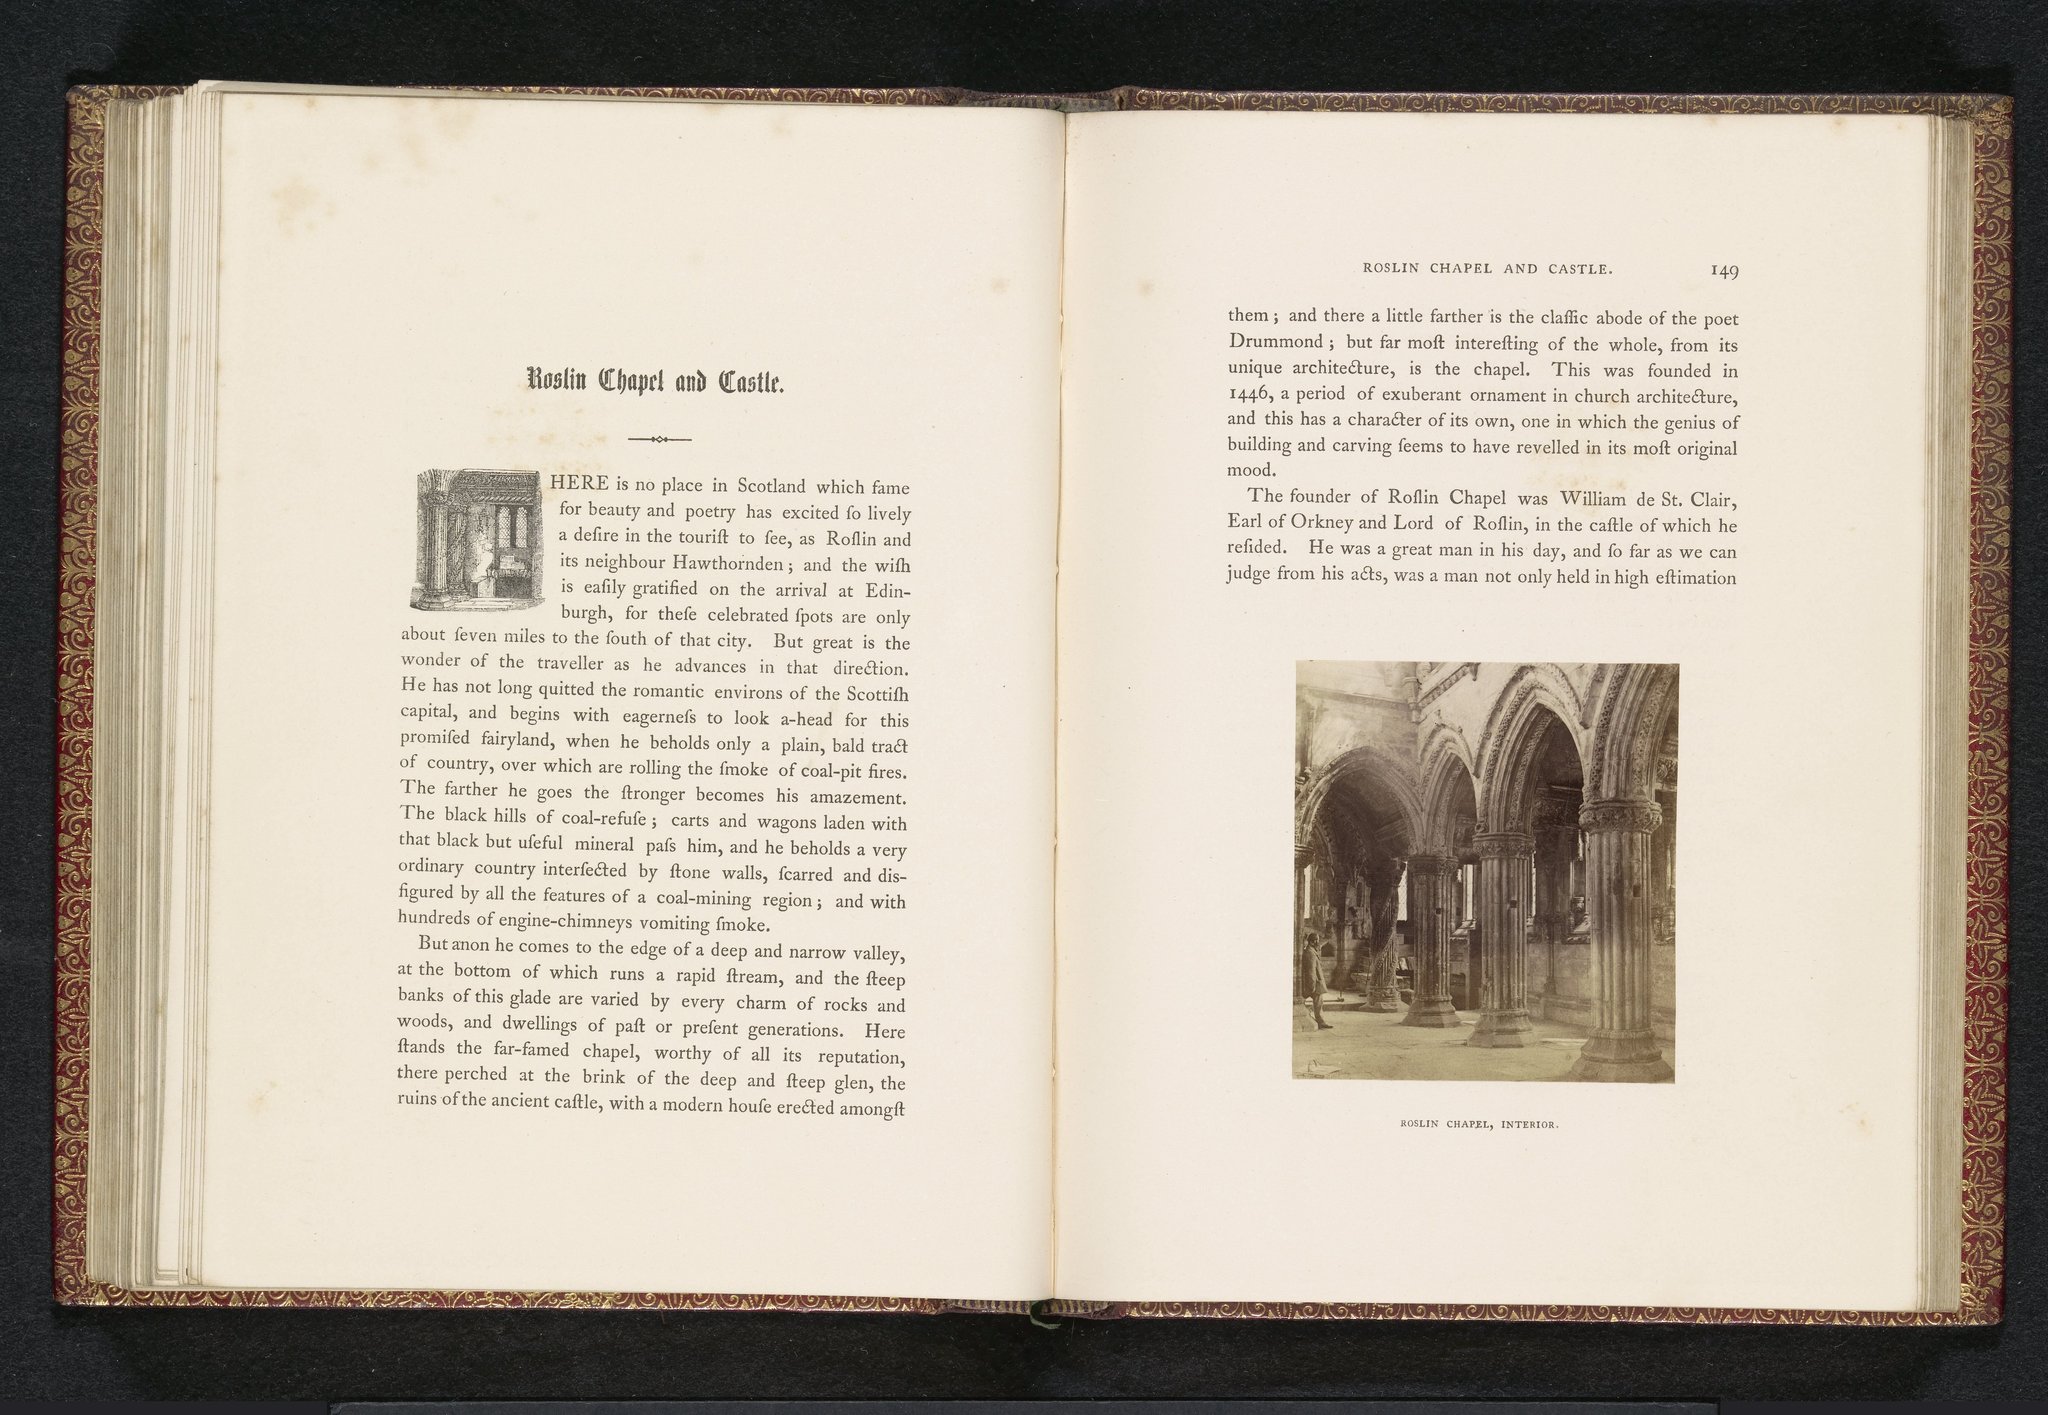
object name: photograph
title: Ruïne van het interieur van de Rosslyn Chapel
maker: george washington wilson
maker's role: publisher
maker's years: 1823-1893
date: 1852-1862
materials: photographic support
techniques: albumen print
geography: rosslyn chapel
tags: parts of church exterior and annexes: chapel, ruin of church, monastery, etc.